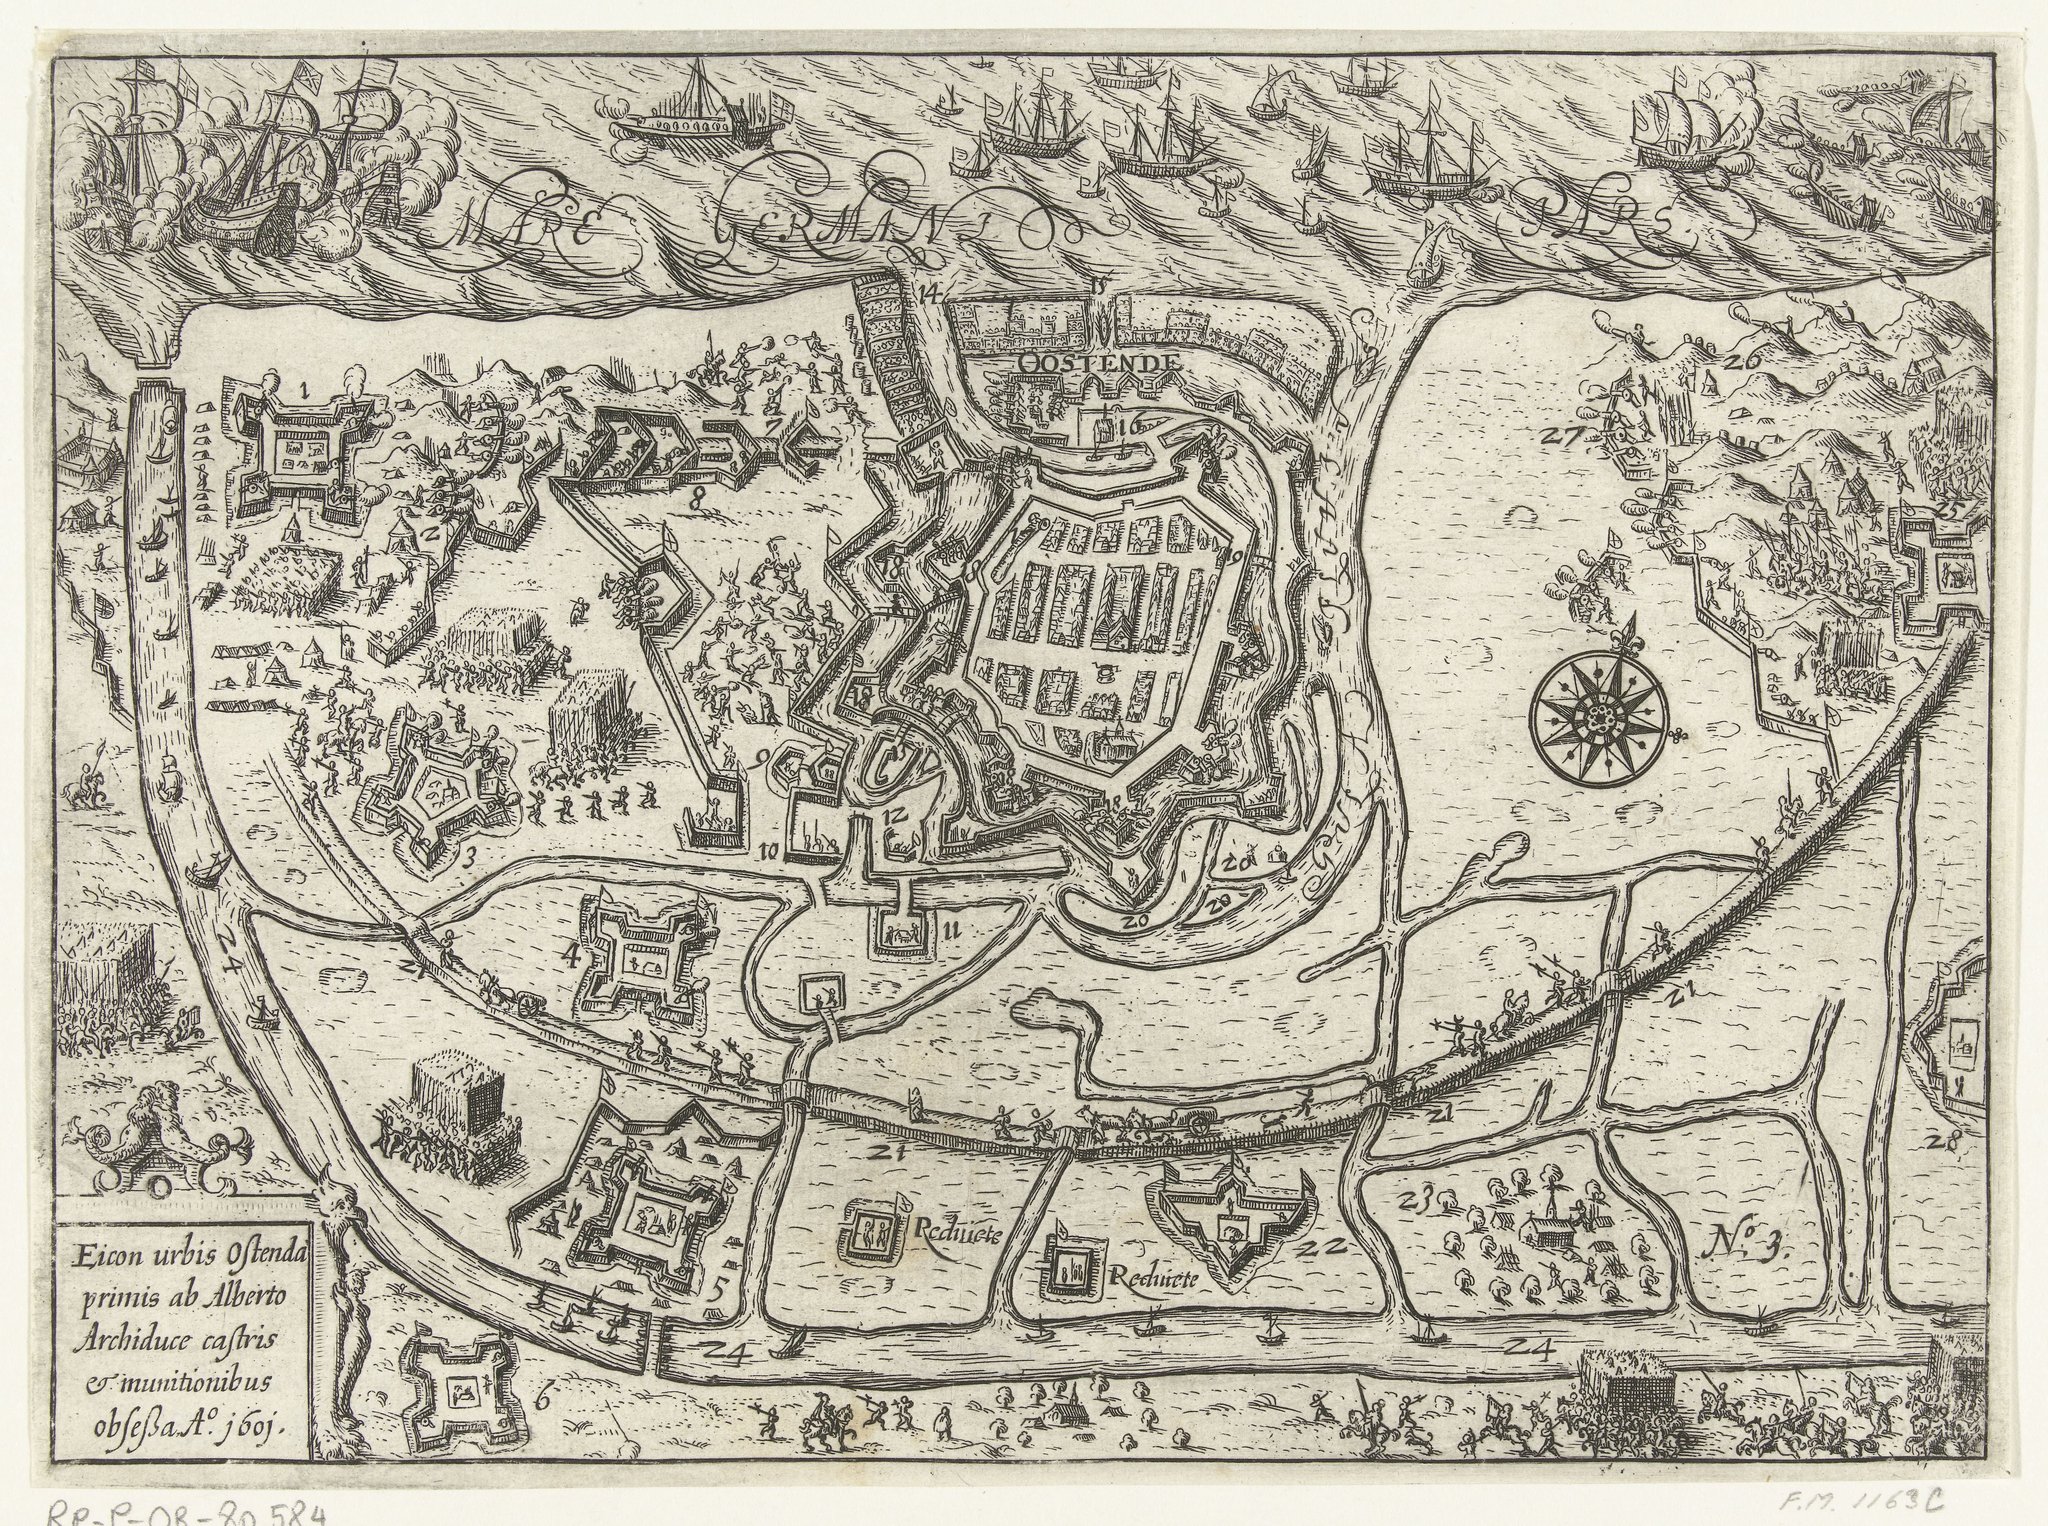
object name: history print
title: Beleg van Oostende, 1601-1604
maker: Anonymous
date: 1611-1613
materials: paper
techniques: etching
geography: low countries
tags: brussels, albrecht aartshertog van oostenrijk, siege, position war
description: Eerst gebruikt als illustratie in: Henrick Lodewijcxsoon van Haestens, De bloedige ende strenge belegeringhe der stadt Oostende in Vlaenderen, H.L. van Haestens, Leiden 1613. Later ook in de Franse editie van dit werk uit 1615 en in Philippe Fleming, Oostende, vermaerde, gheweldighe, lanckduyrighe ende bloedighe belegheringhe, bestorminghe ende stoute aenvallen ..., A. Meuris, 's-Gravenhage 1621.